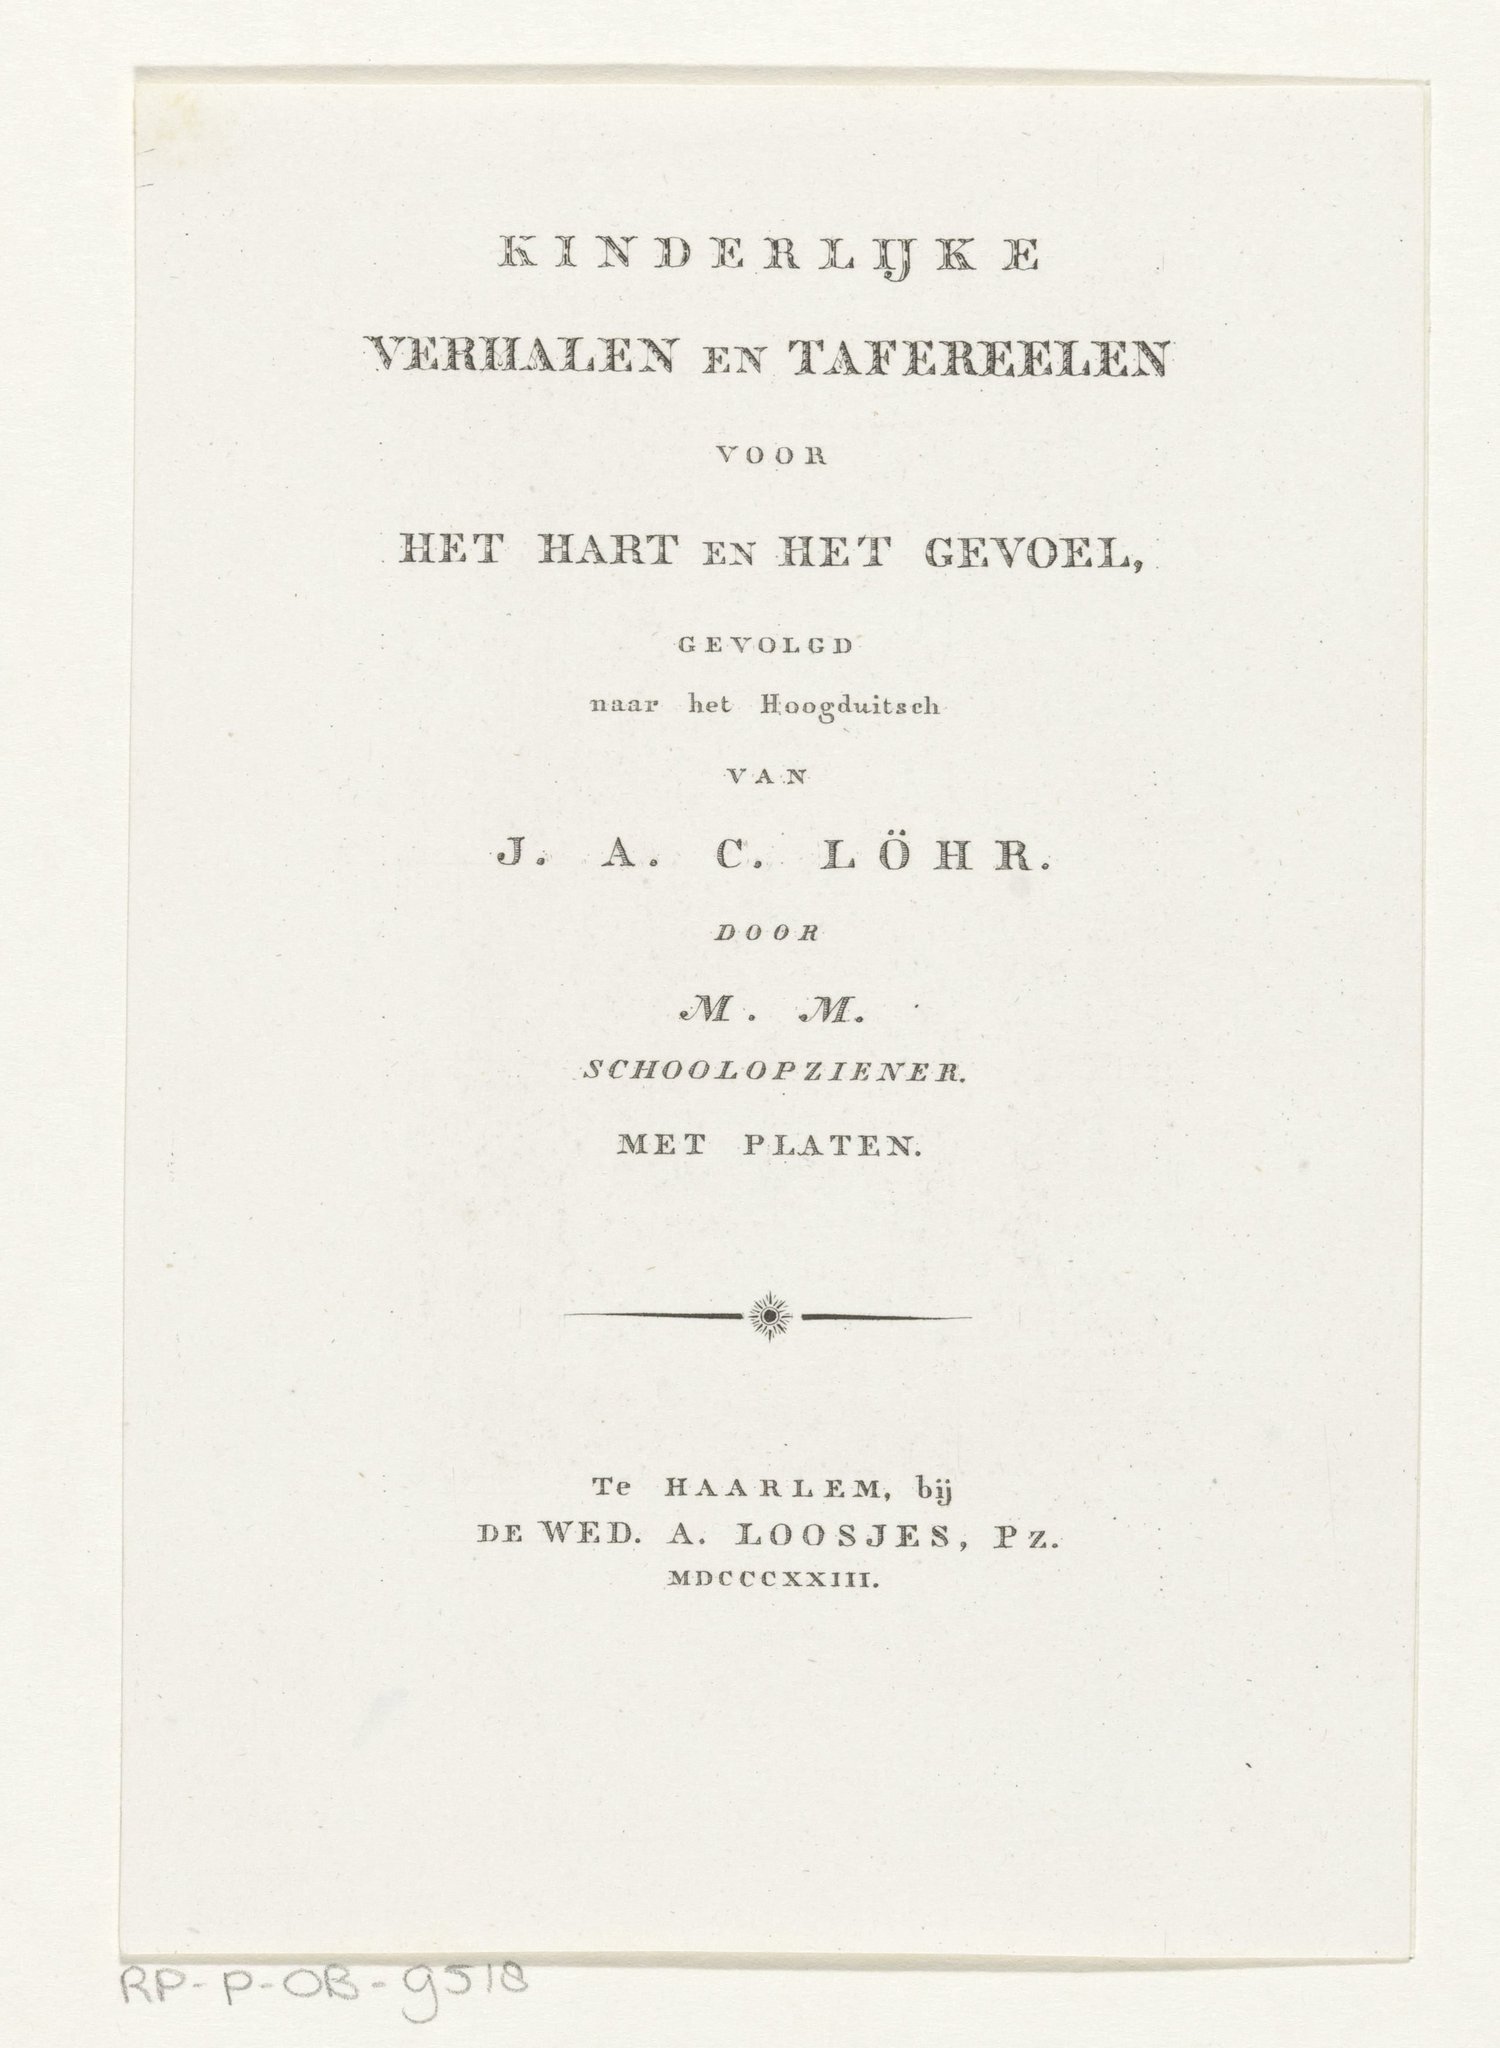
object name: print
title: Titelpagina voor: J.A.C. Löhr, Kinderlijke verhalen en tafereelen voor het hart en het gevoel, 1823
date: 1823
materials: paper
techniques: engraving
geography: haarlem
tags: title-page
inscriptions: collector's mark: Lugt 2228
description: Titelpagina voor: Löhr, J.A.C. Kinderlijke verhalen en tafereelen voor het hart en het gevoel. Haarlem: Loosjes Pz., weduwe Adriaan, 1823.